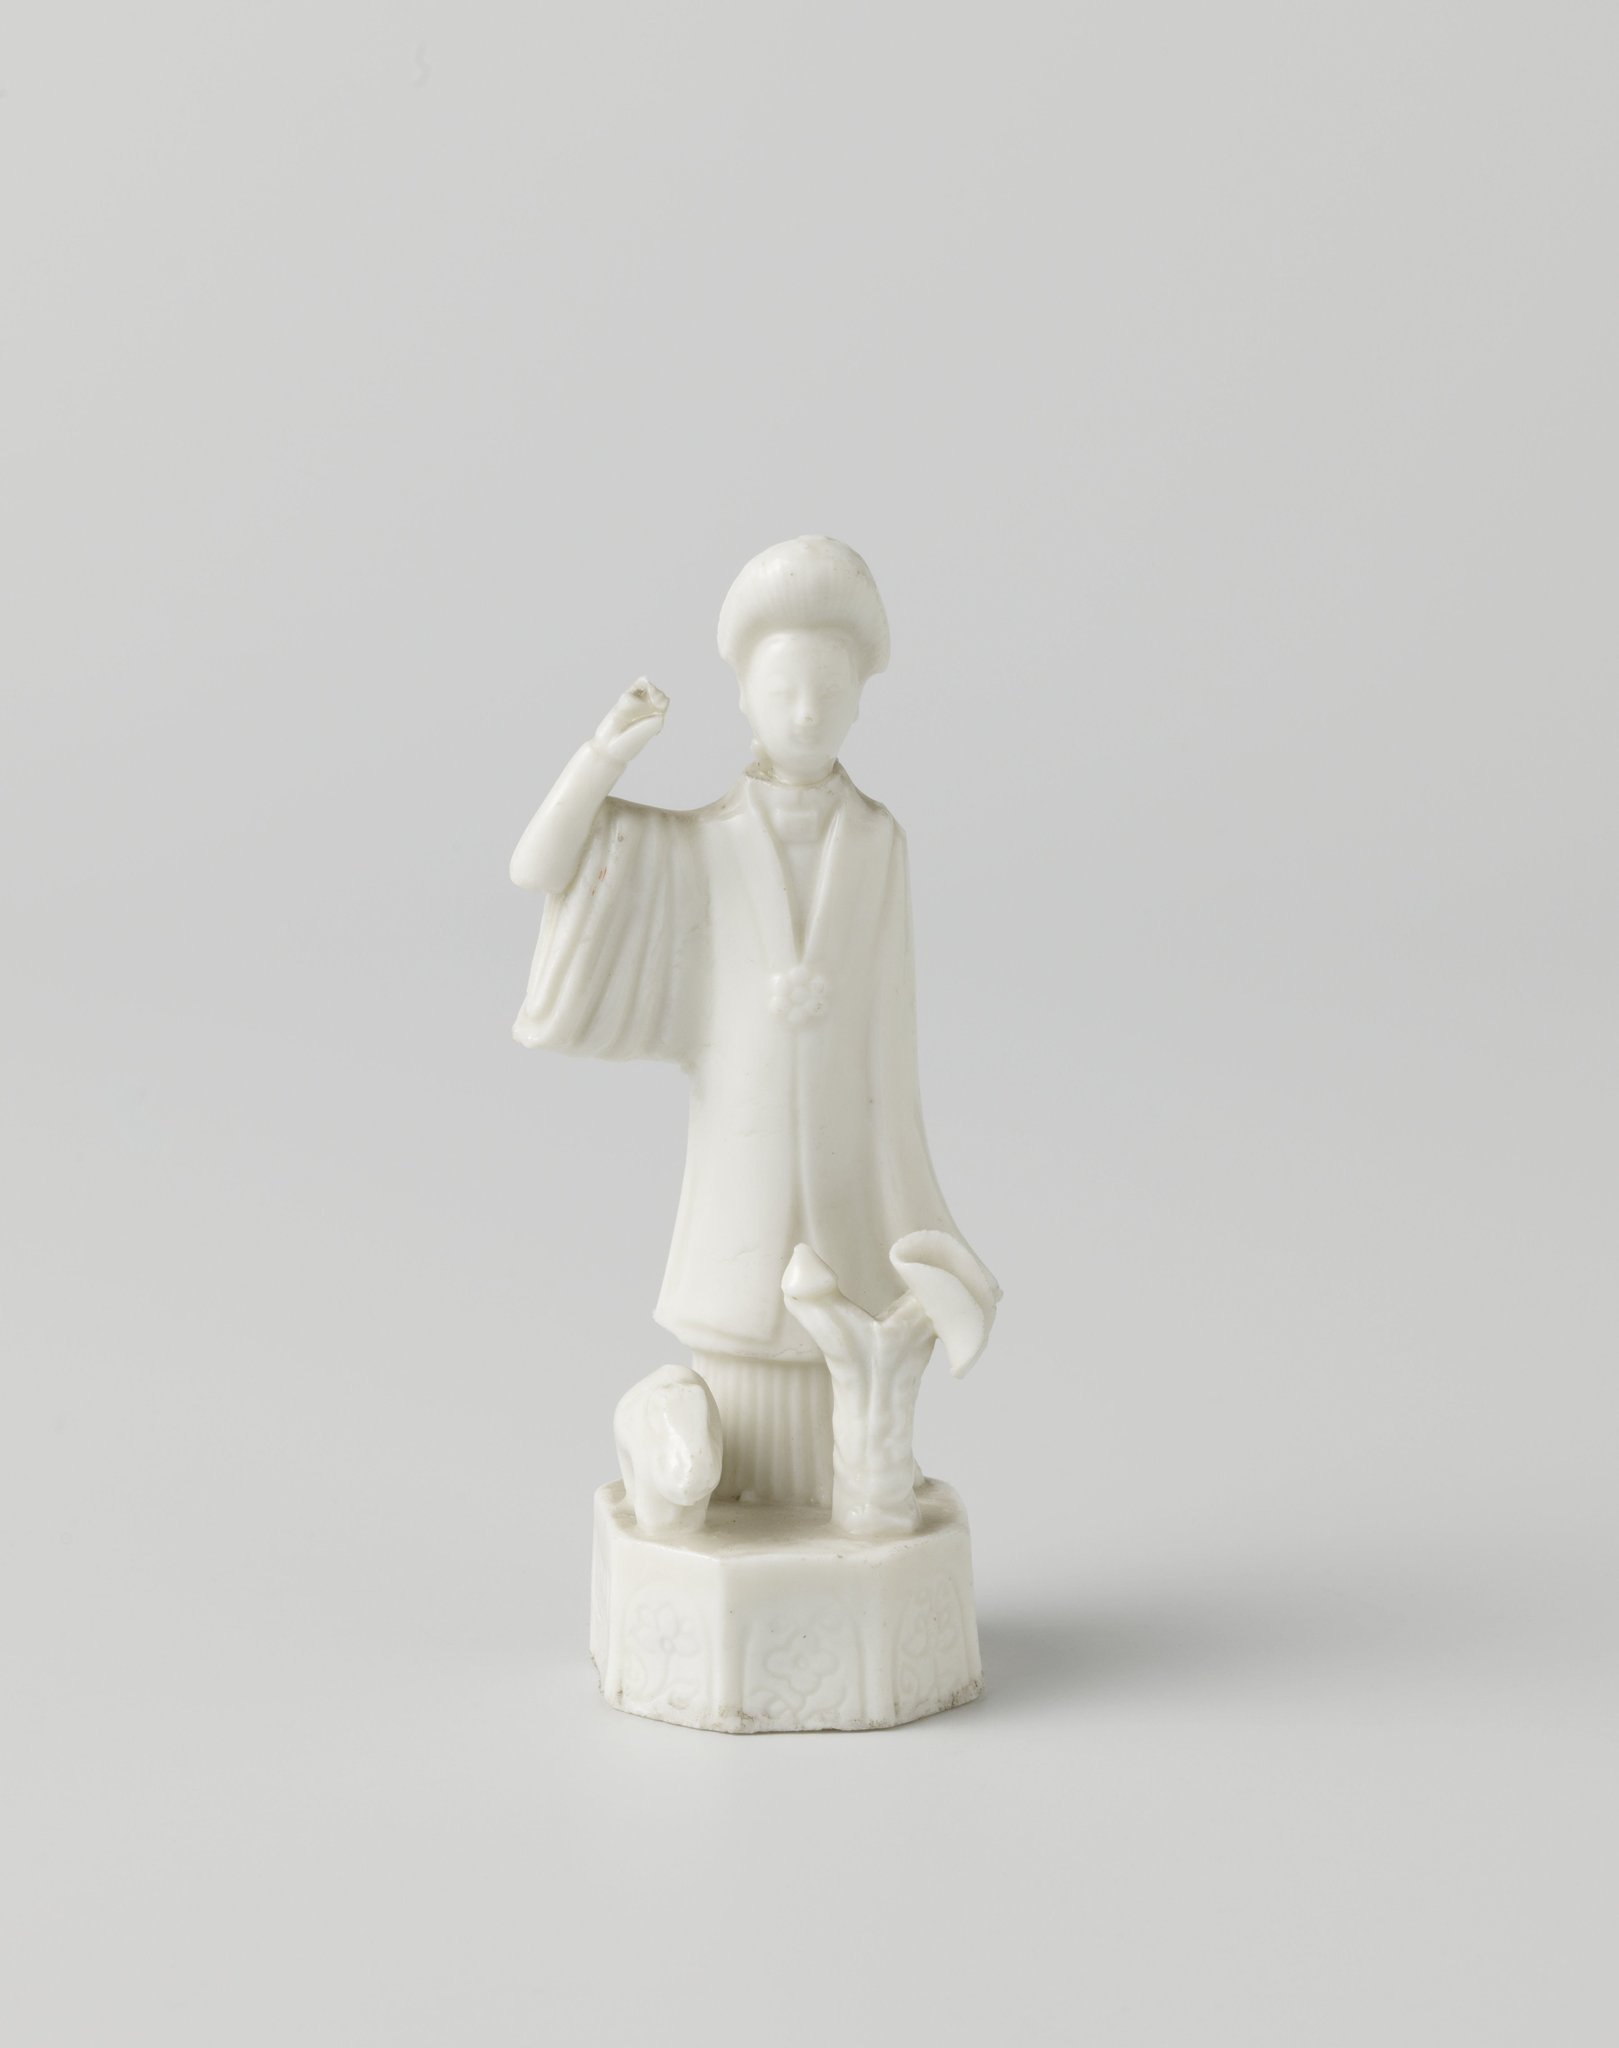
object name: figure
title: Figure of a woman with a rabbit and fungus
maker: Anonymous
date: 1700-1799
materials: glaze, porcelain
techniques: firing, forming, vitrification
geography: china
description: Beeld van 'blanc de Chine' voorstellende een vrouw met opgeheven rechterarm. Op het achtkantige voetstuk een marmot en een plant.